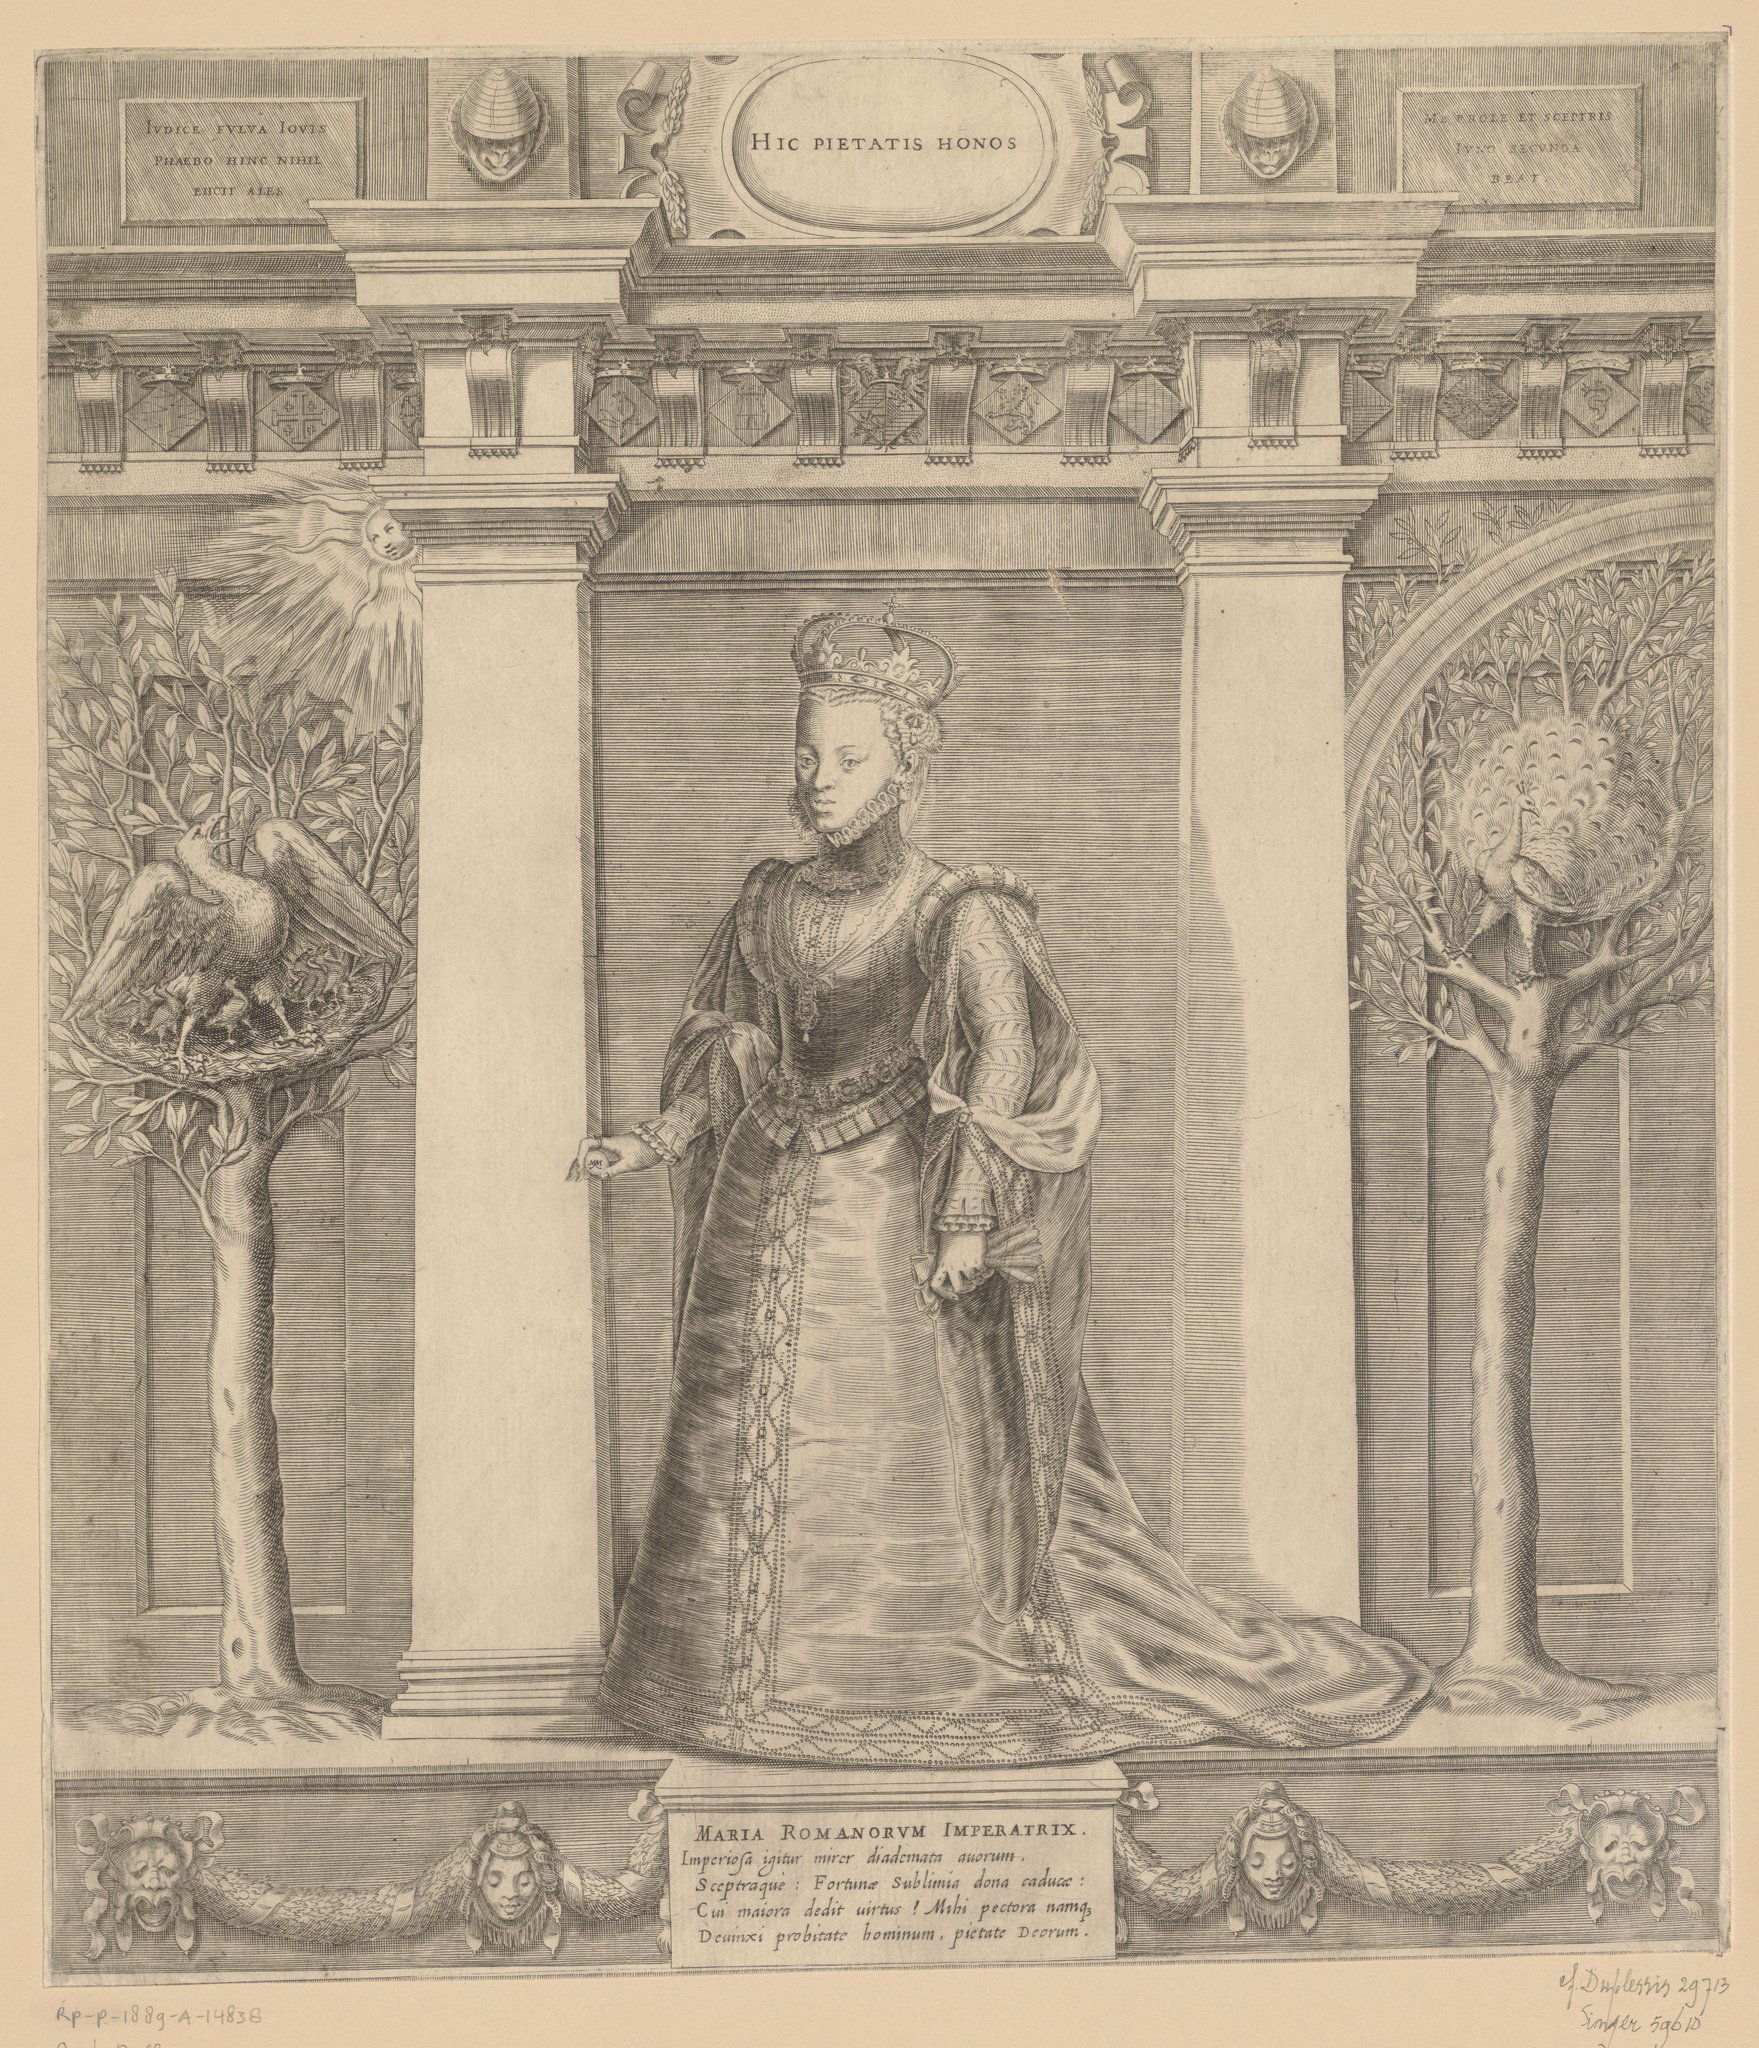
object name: print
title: Portretten van leden van het Oostenrijkse Huis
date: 1569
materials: paper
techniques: engraving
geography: italy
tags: maria (koningin van bohemen), historical persons - bb - woman, trees: laurel, ornamental birds: peacock, emperor - bb - female ruler, water-birds: pelican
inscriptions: collector's mark: Lugt 2228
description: Deze prent maakt deel uit van een reeks van 58 prenten. Het meerendeel van de prenten bevat portretten van 74 leden van het Oostenrijkse Huis, naar tekeningen door Francesco Terzio, die deels getekend zijn naar de 28 levensgrote bronzen beelden die rond de cenotaaf van Maximiliaan I in de Hofkirche te Innsbruck staan.